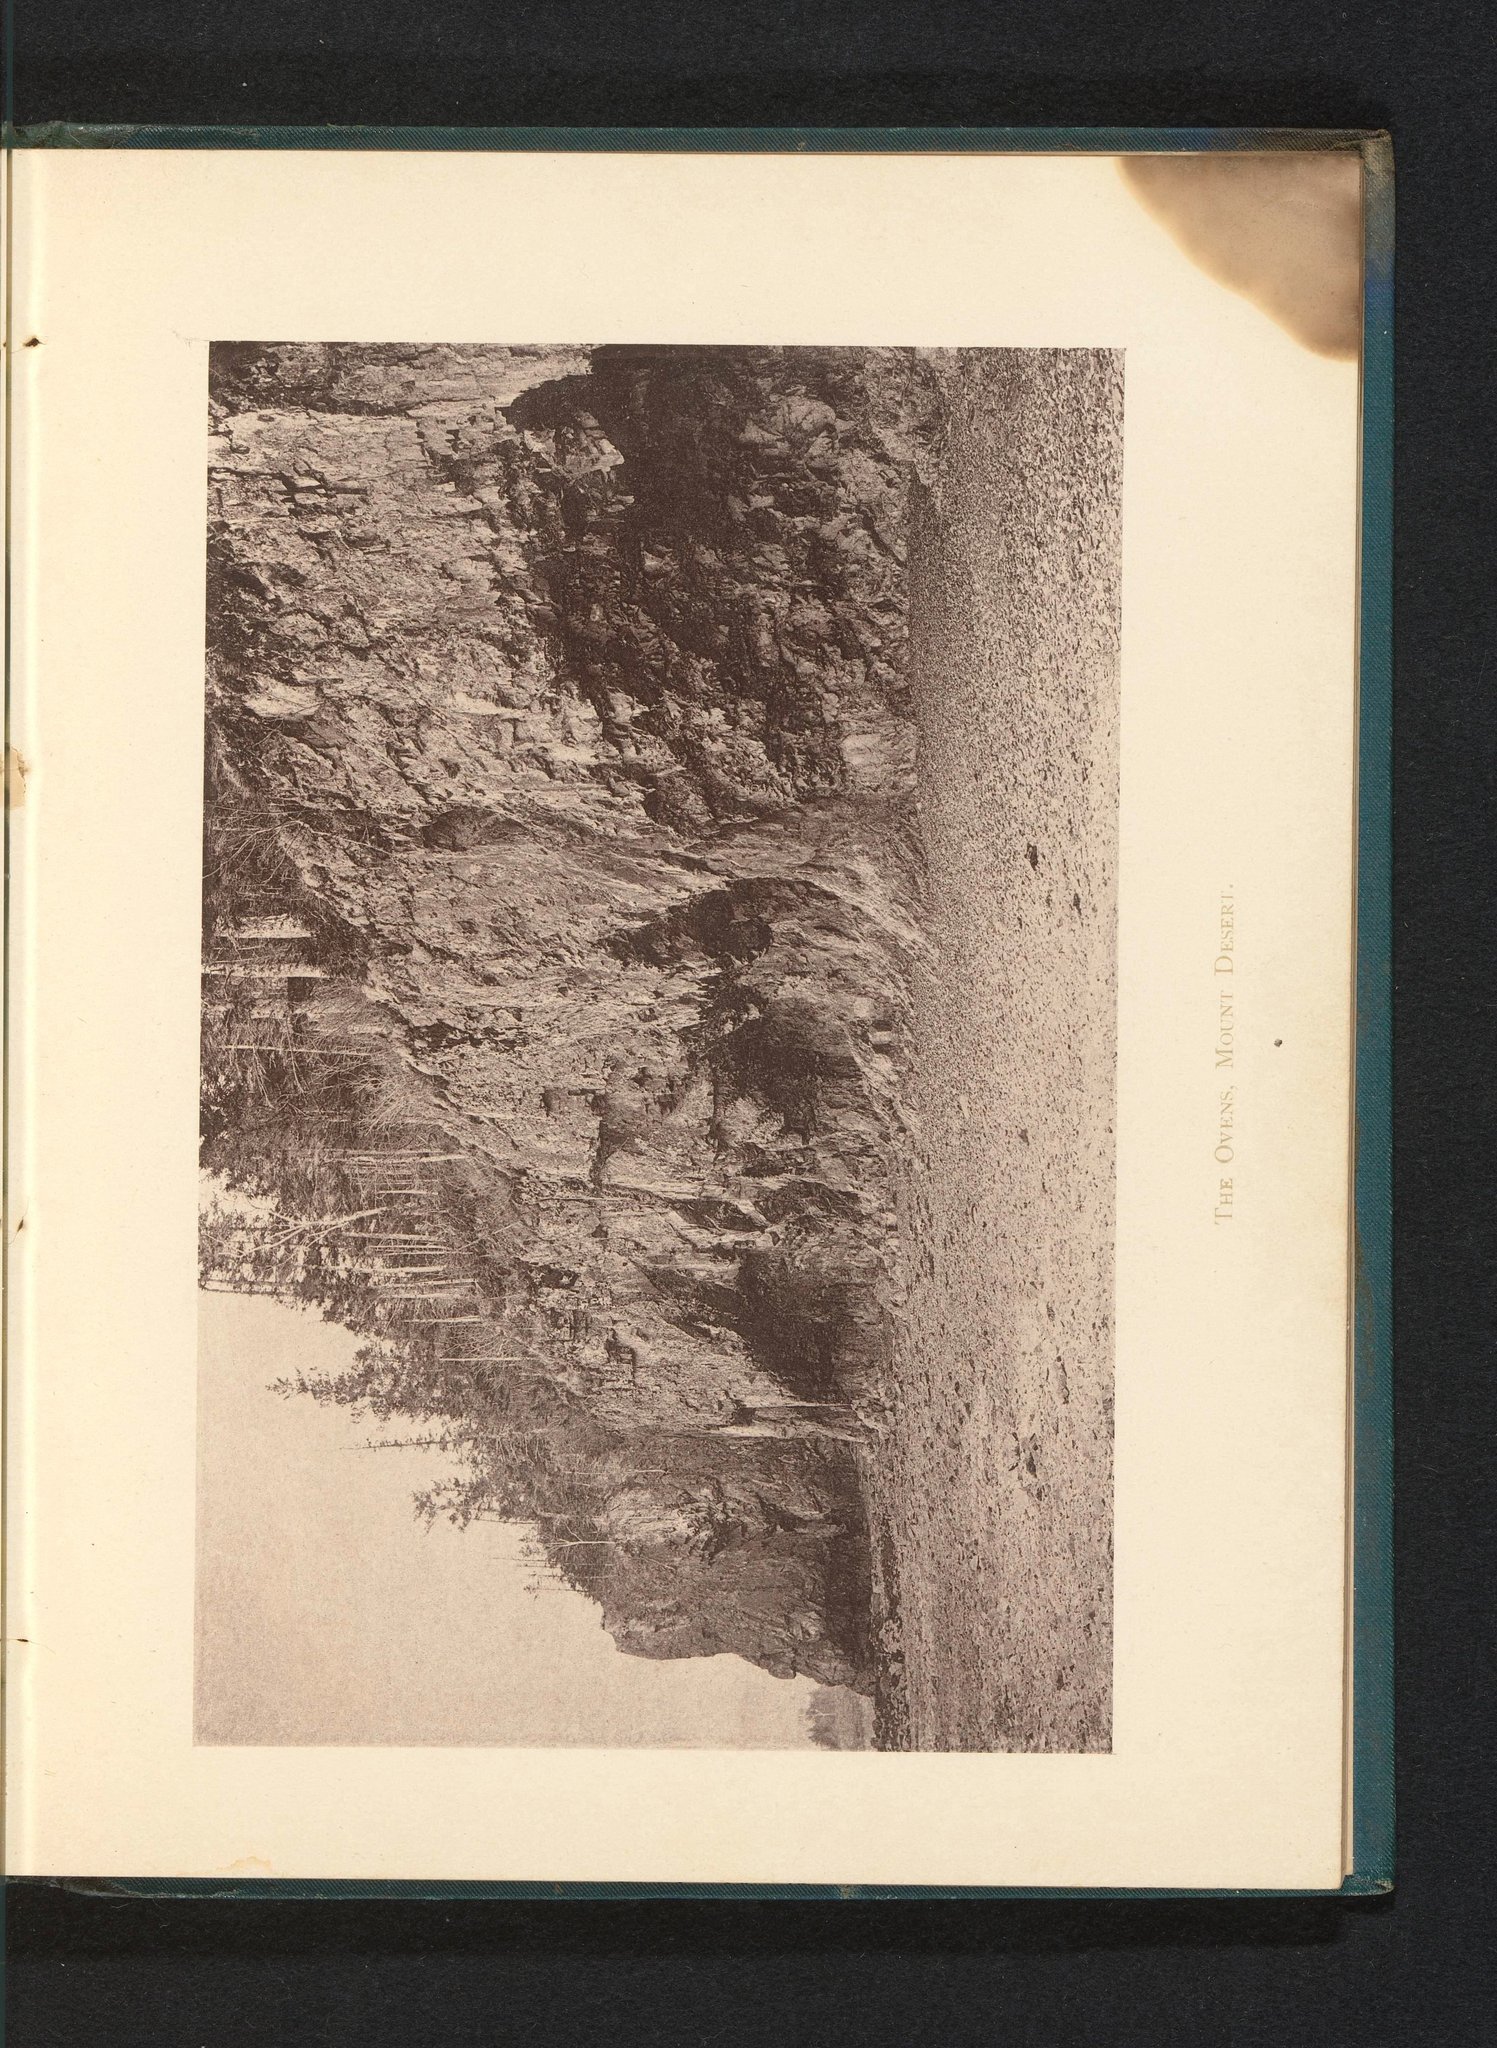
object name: photomechanical print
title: The Ovens, Mount Desert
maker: Anonymous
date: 1875-1880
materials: paper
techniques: photograph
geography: the ovens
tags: rock-formations